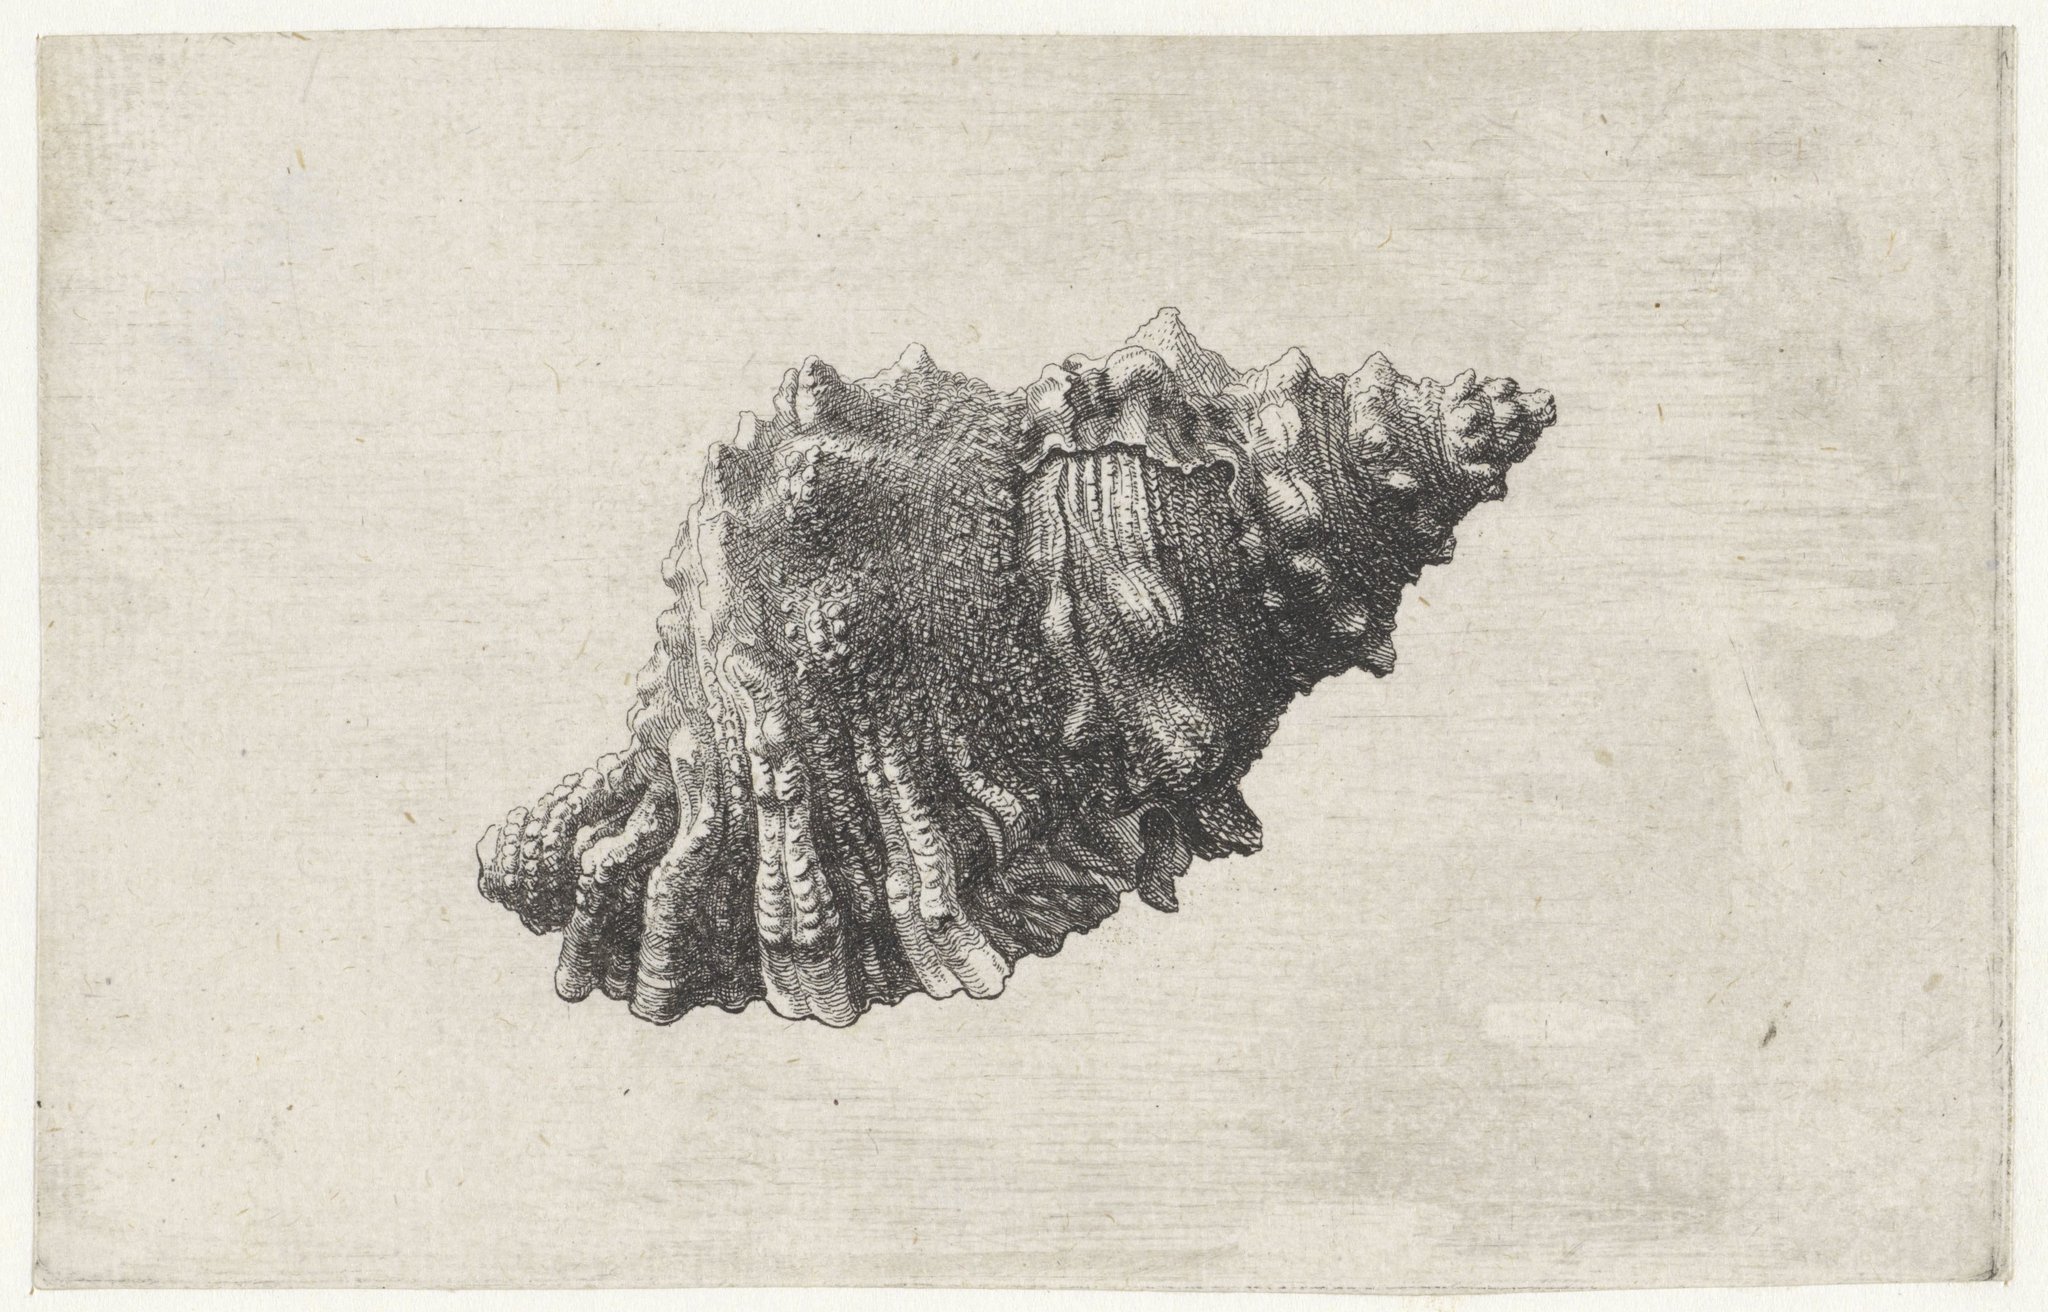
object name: print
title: Schelp, bursa rubeta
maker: wenceslaus hollar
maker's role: draughtsman, print maker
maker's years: 1607-1677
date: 1644-1652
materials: paper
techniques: etching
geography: antwerp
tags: molluscs (+ shell, snail-shell etc.)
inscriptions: collector's mark: Lugt 240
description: Prent maakt deel uit van een 39-delige serie met verschillende soorten schelpen.